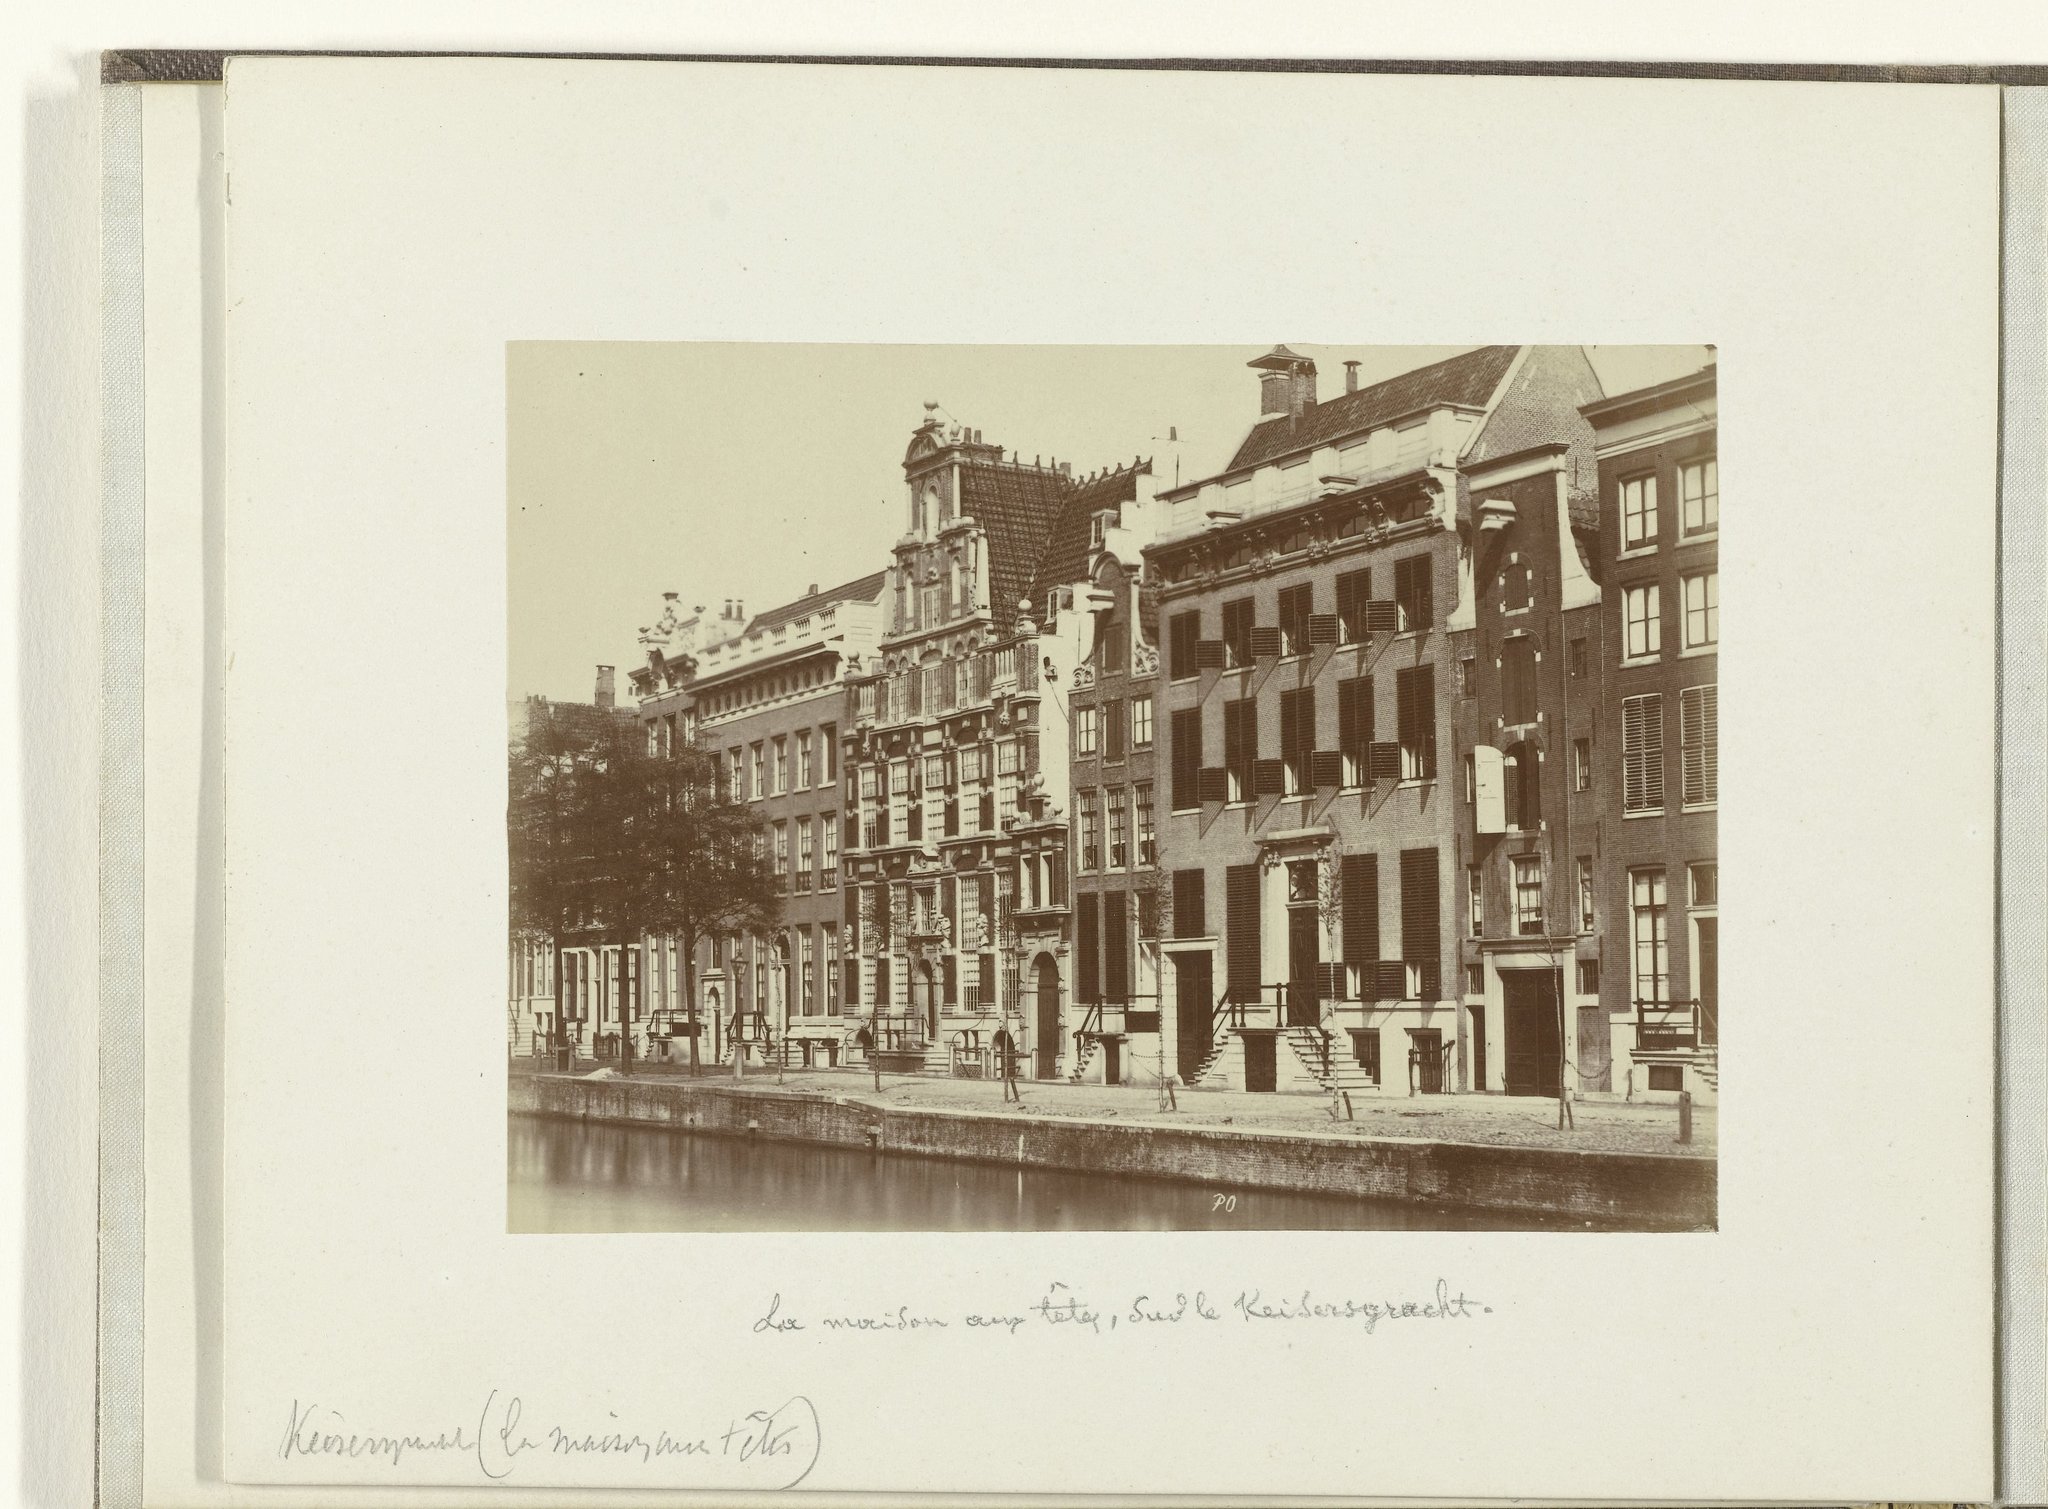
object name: photograph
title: Keizersgracht (la maison aux têtes)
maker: pieter oosterhuis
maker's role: draughtsman, print maker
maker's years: 1816-1885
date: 1855-1860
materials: paper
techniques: albumen print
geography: amsterdam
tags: urban housing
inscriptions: inscription: ‘La maison aux têtes, sur le Keizersgracht.’